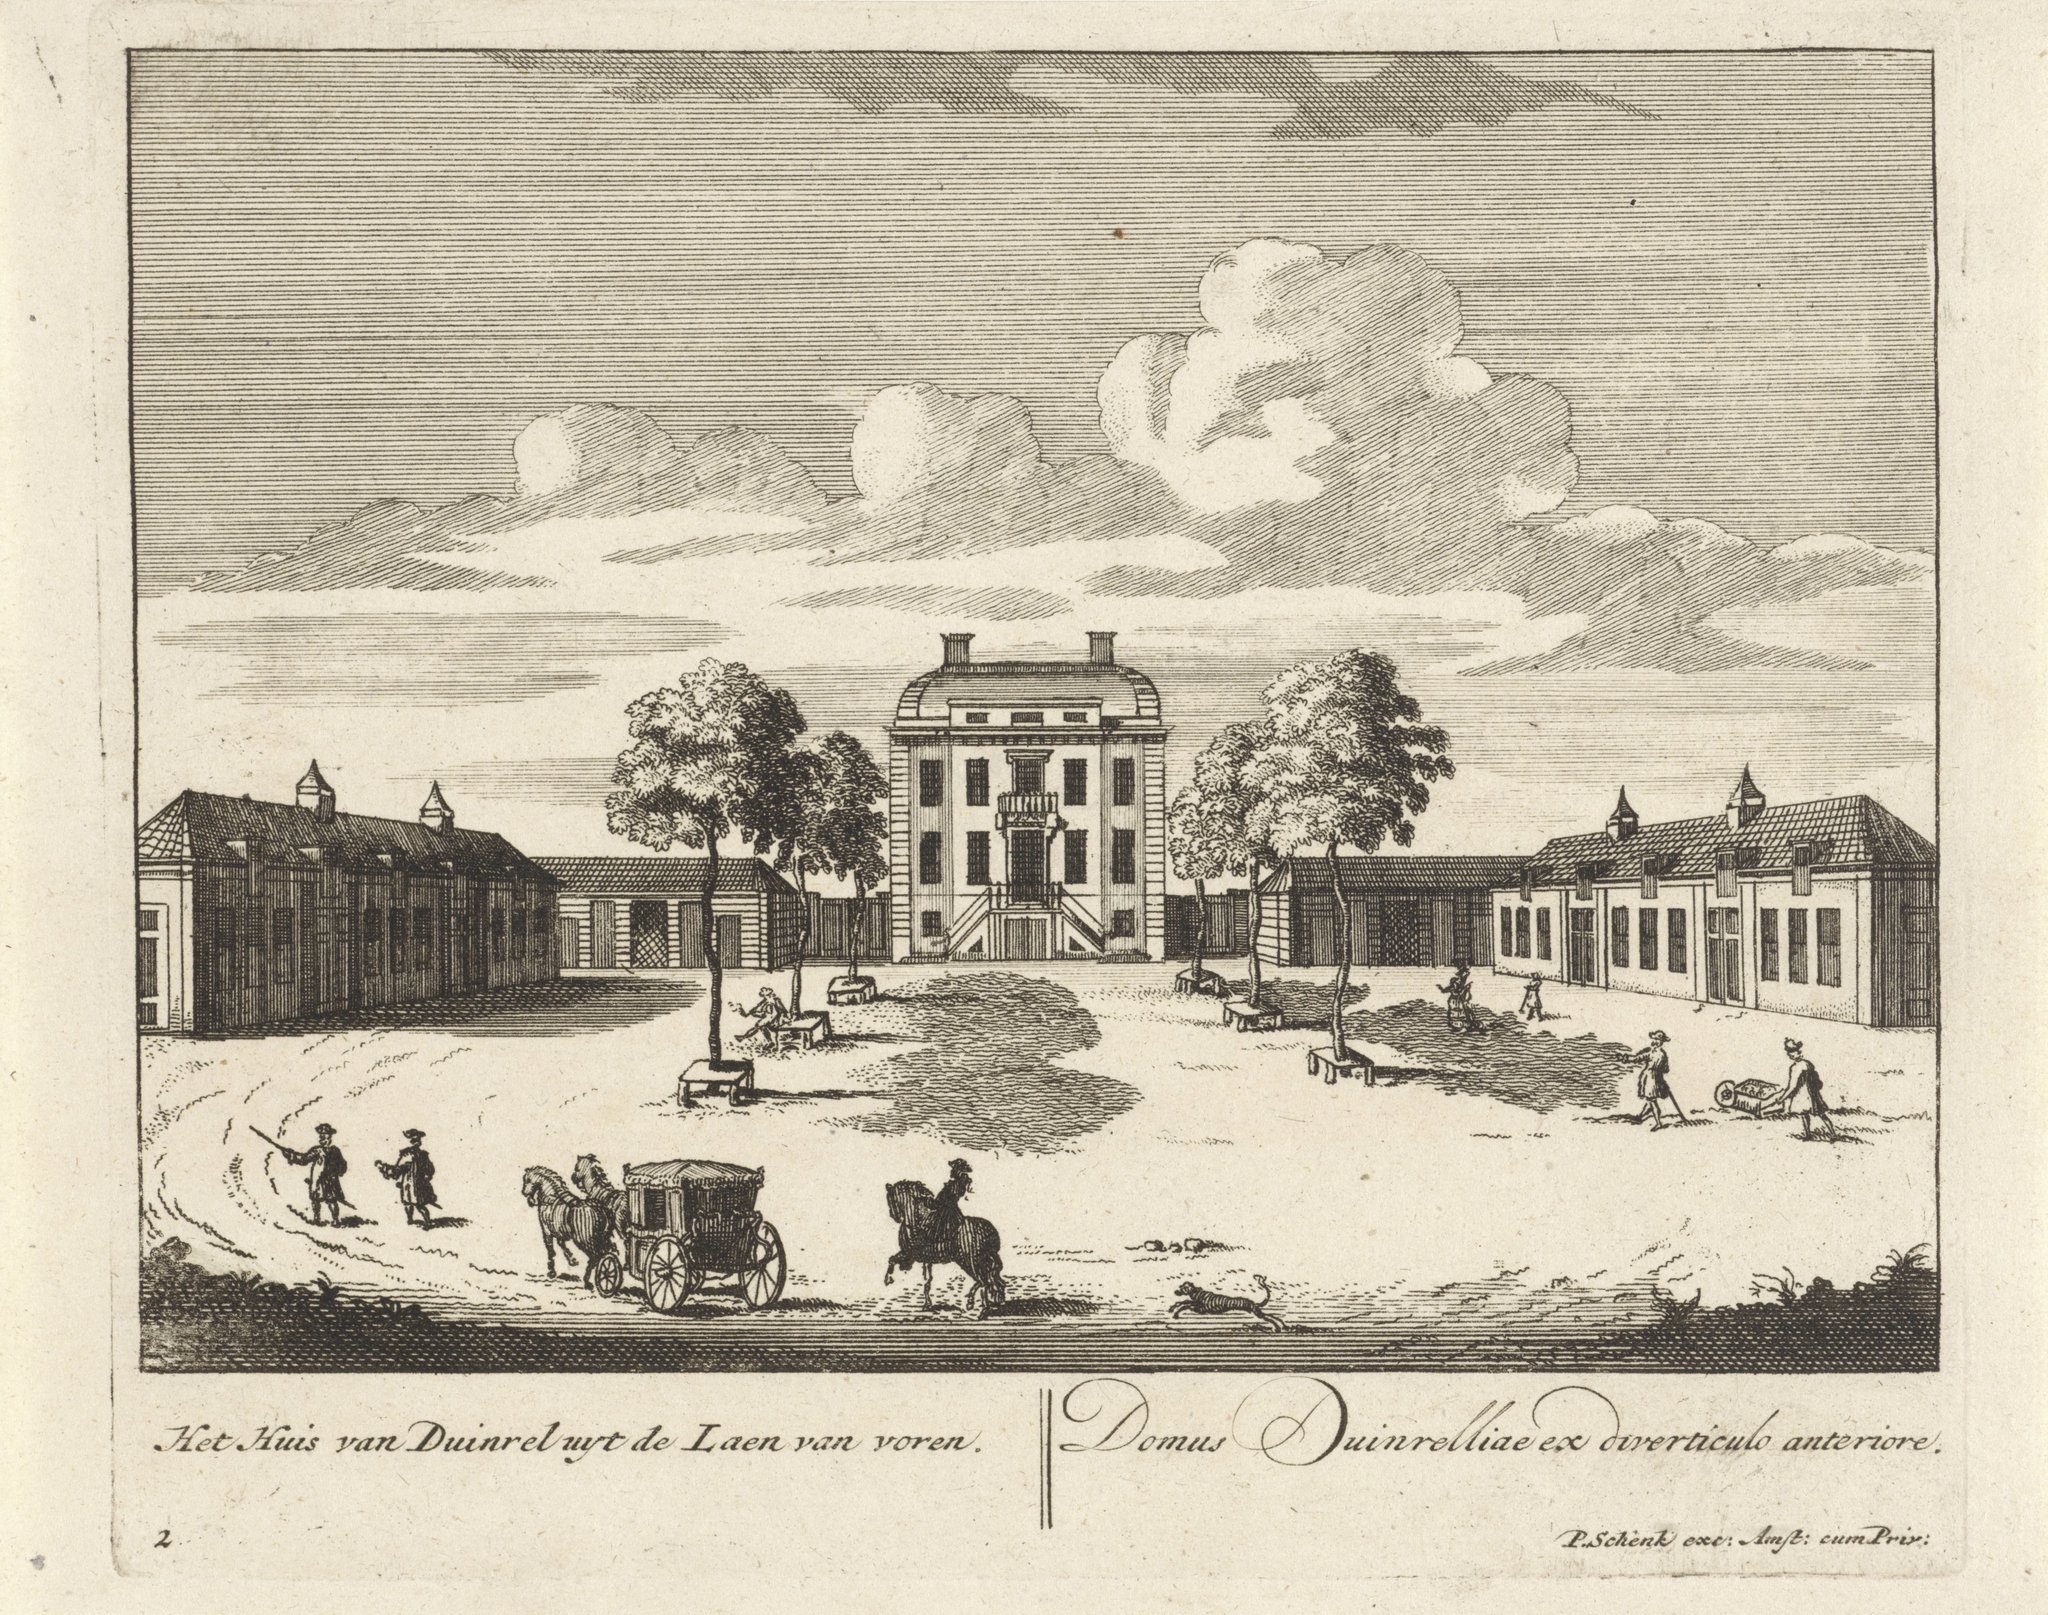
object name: print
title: Gezichten op de buitenplaats Duinrell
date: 1675-1711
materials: paper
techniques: etching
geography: amsterdam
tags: four-wheeled, animal-drawn vehicle, e.g.: cab, carriage, coach, country-house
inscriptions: collector's mark: Lugt 2228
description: Gezicht op het voorplein en het huis van buitenplaats Duinrell. Linksonder genummerd: 2. Prent uit een serie van zestien prenten van Duinrell.